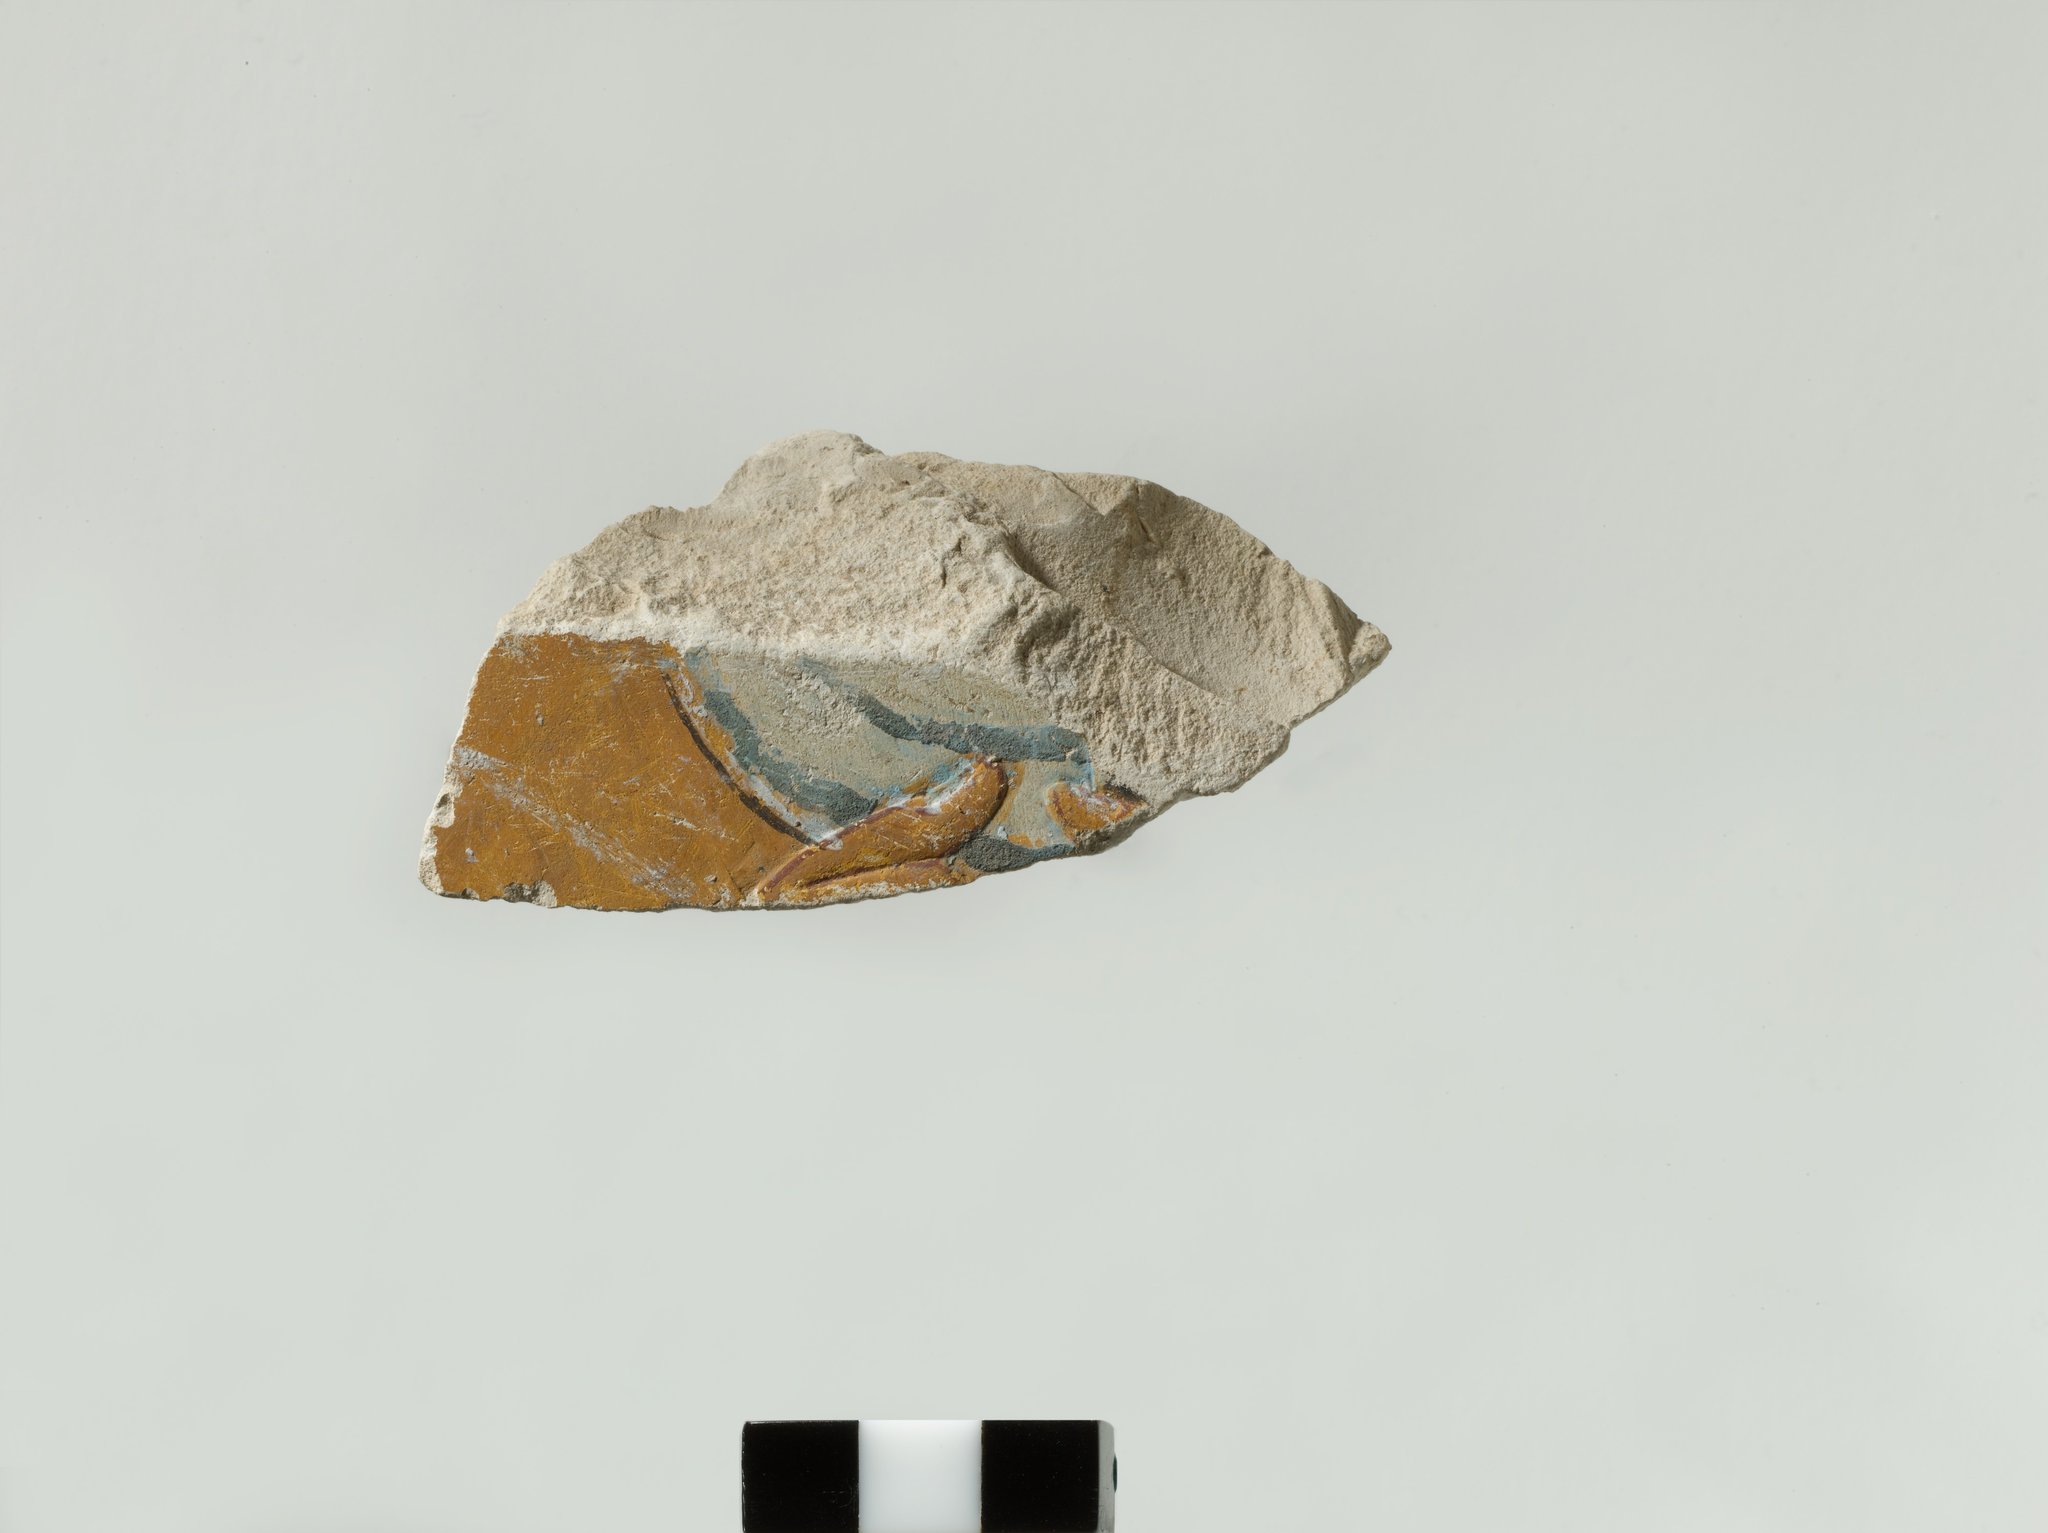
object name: relief fragment, tomb of meketre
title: Relief fragment from the tomb of Meketre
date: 1981-1975 BCE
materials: limestone, paint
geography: egypt